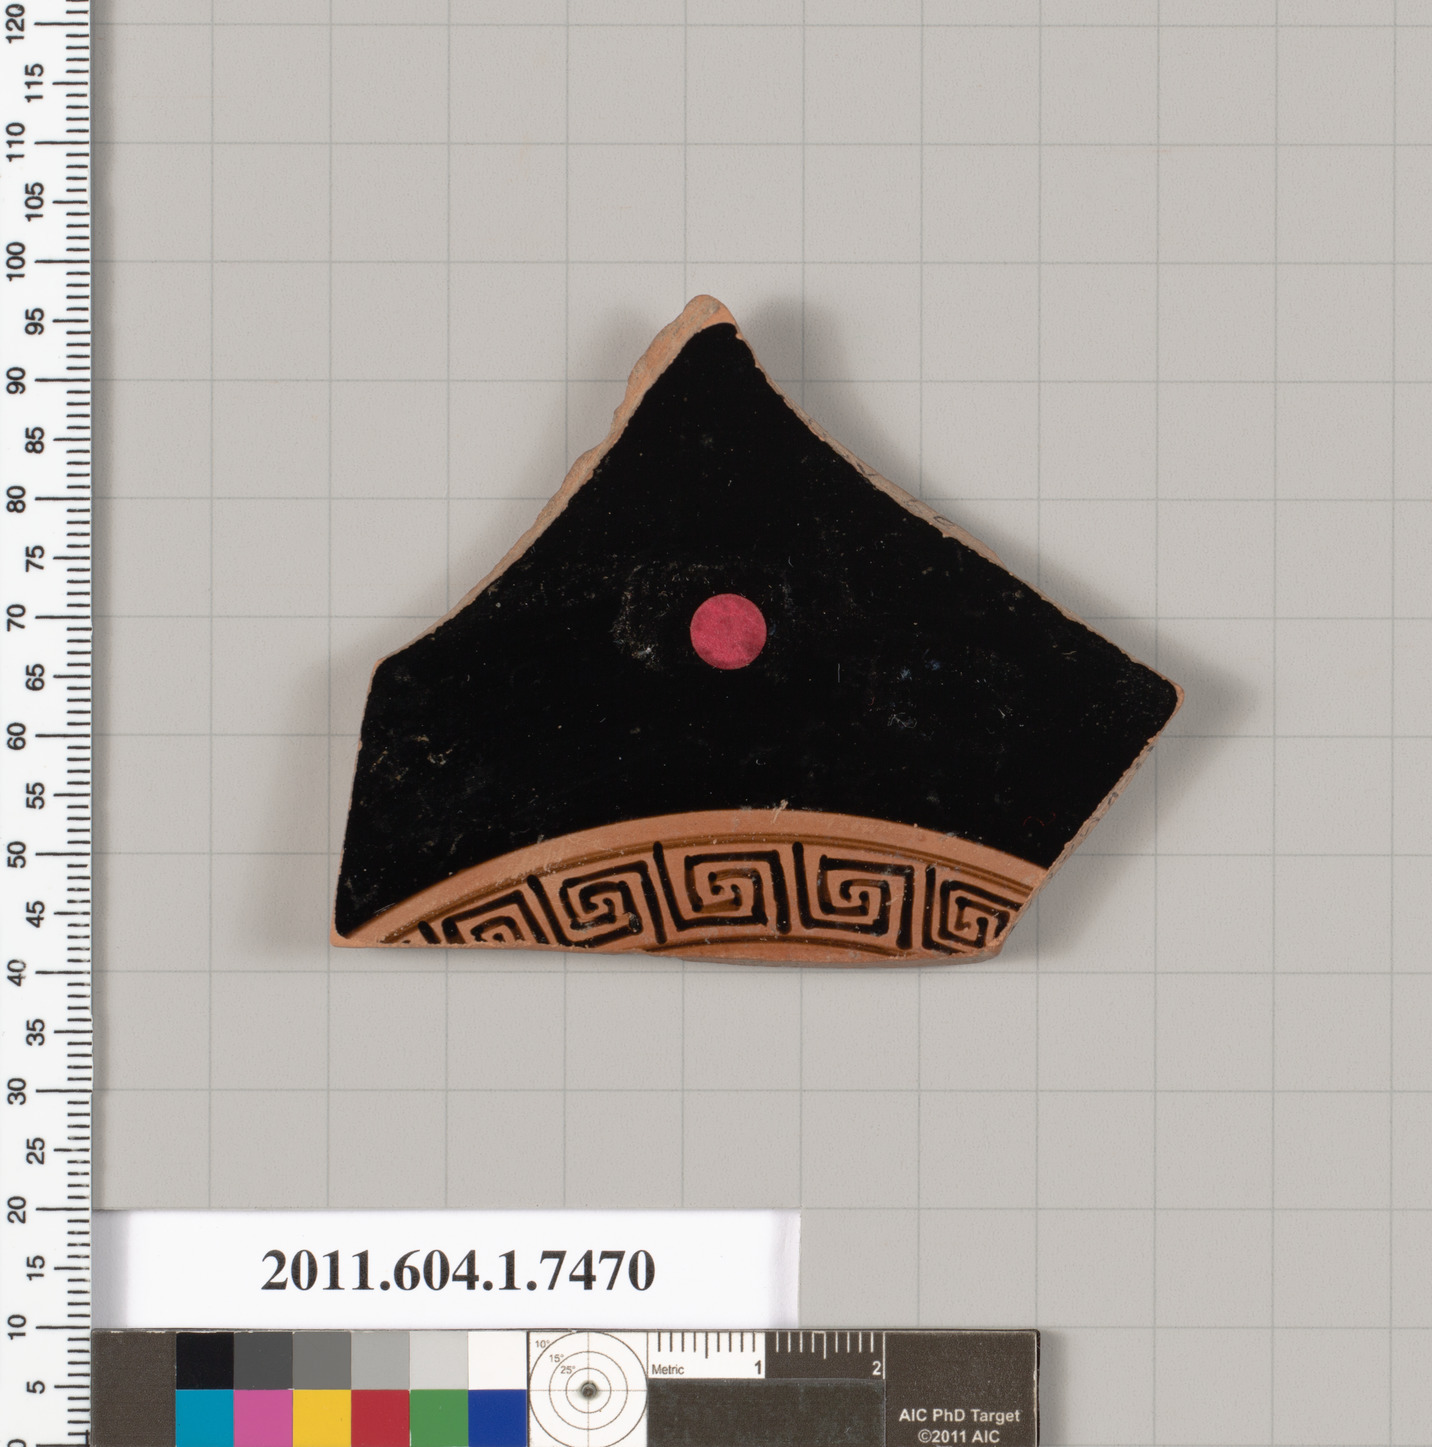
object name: kylix fragment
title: Terracotta fragment of a kylix (drinking cup)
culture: greek, attic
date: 470-460 BCE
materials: terracotta